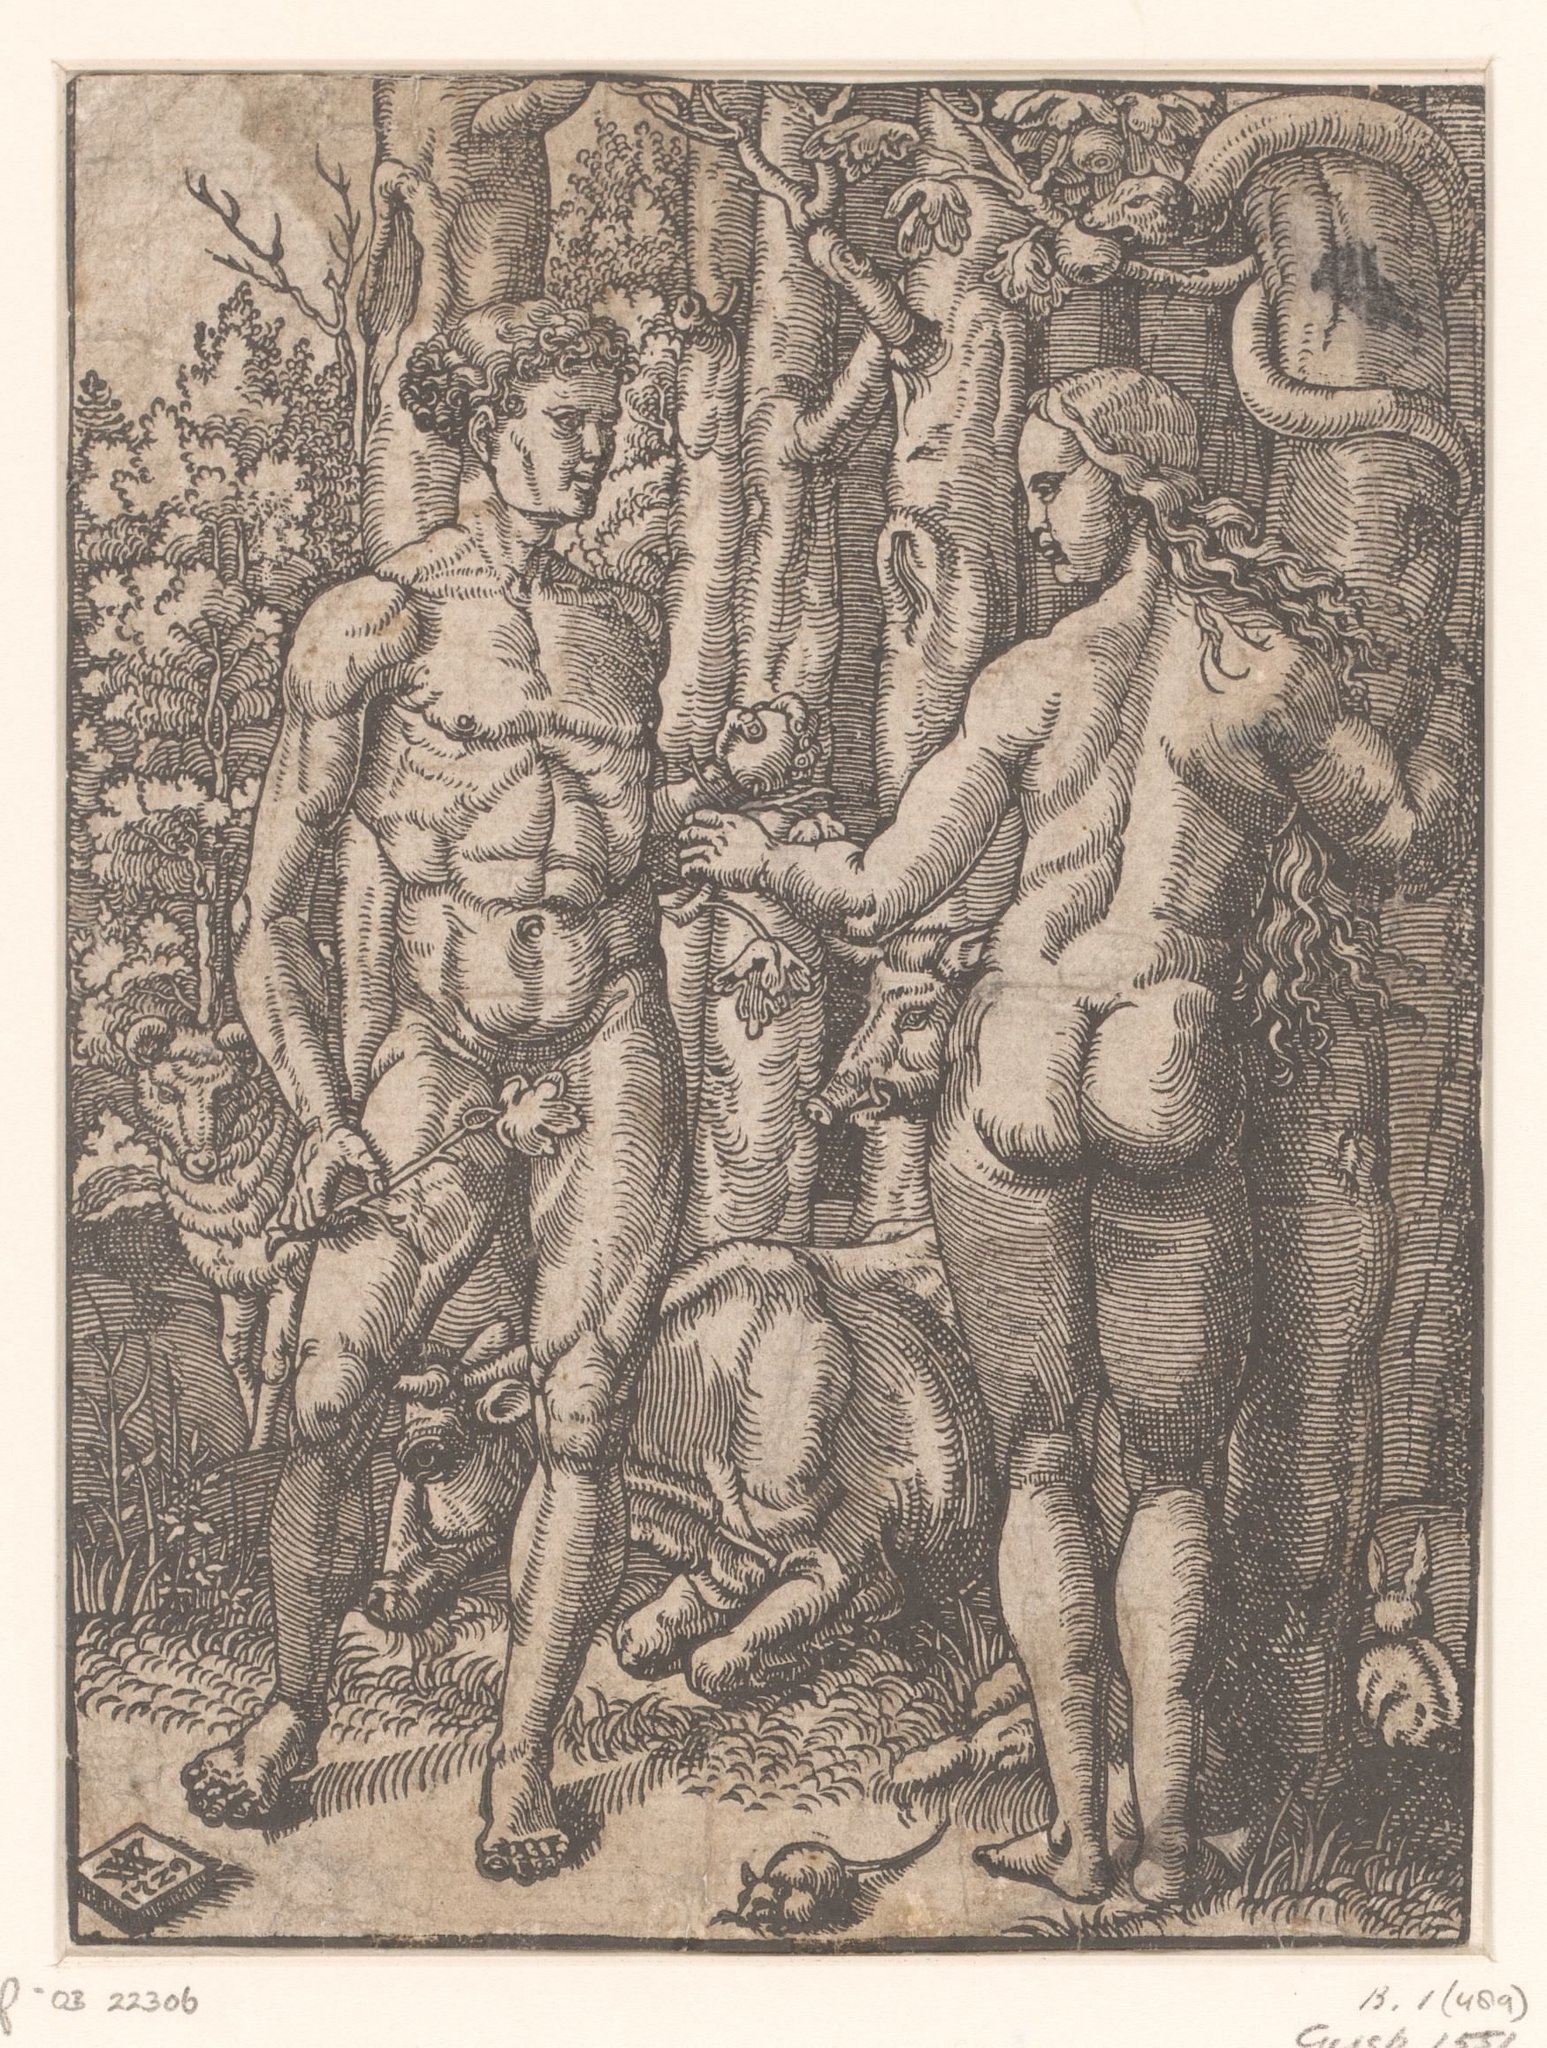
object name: print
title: Adam en Eva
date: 1529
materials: paper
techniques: woodcut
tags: adam and eve (not in biblical context)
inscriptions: collector's mark: Lugt 240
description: Eerste prent in een reeks van mogelijk tien.